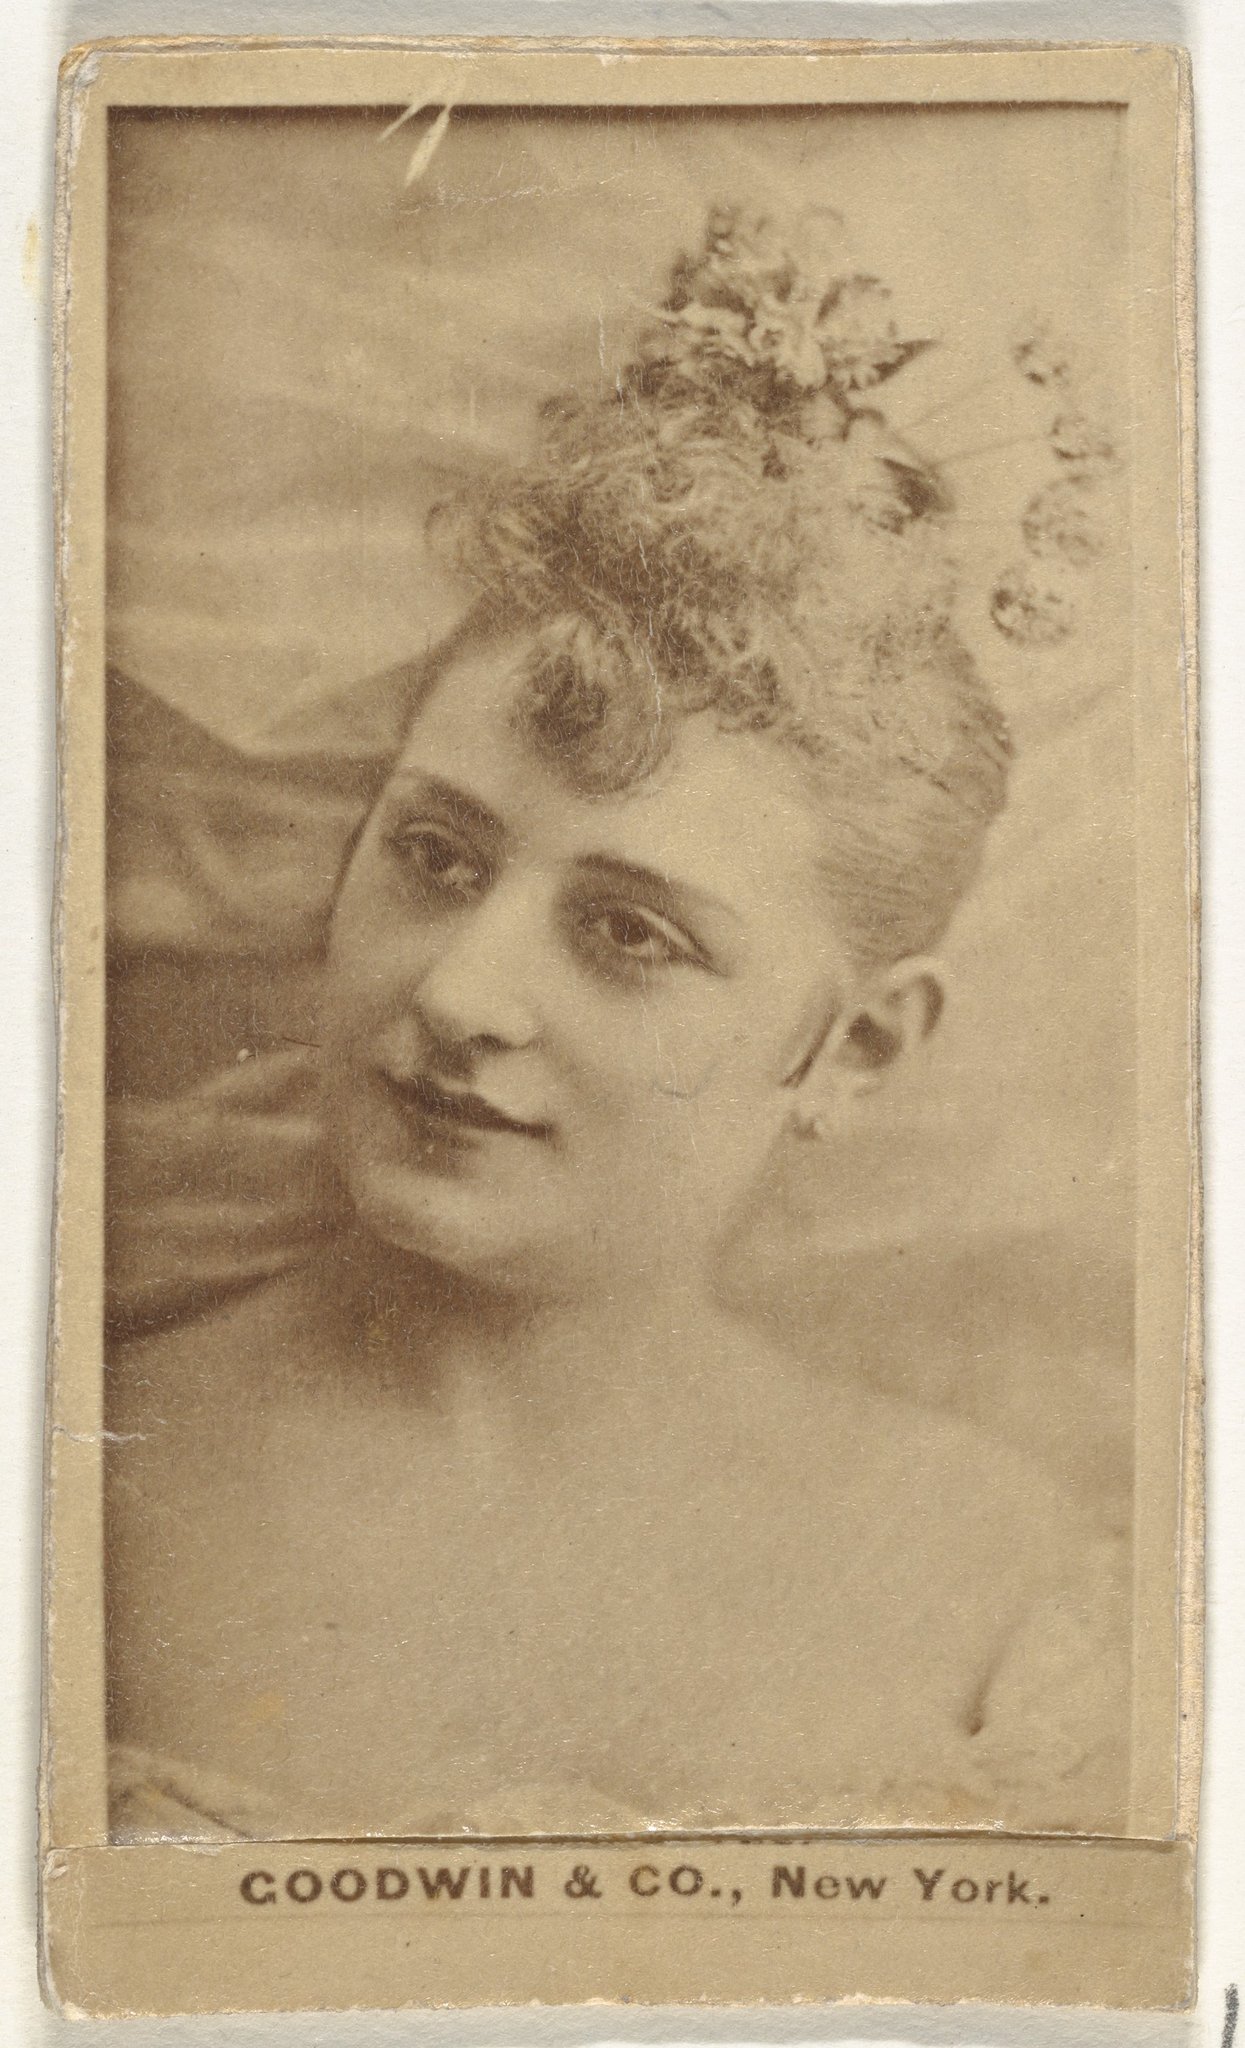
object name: photograph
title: From the Actors and Actresses series (N171) for Old Judge, Gypsy Queen, and Temple Bar Cigarettes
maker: goodwin & company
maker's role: publisher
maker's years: 1850-1950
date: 1886-1890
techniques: albumen silver print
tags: portraits,women,actresses